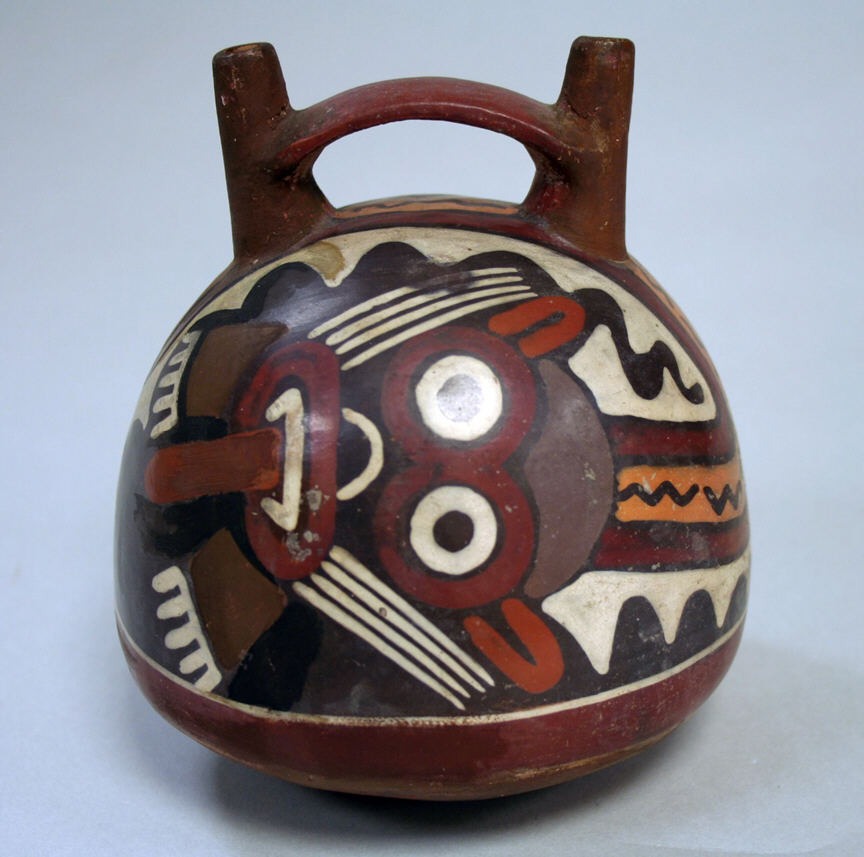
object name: bottle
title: Double Spout and Bridge Bottle with Face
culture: nasca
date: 1-400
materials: ceramic, pigment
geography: peru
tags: faces